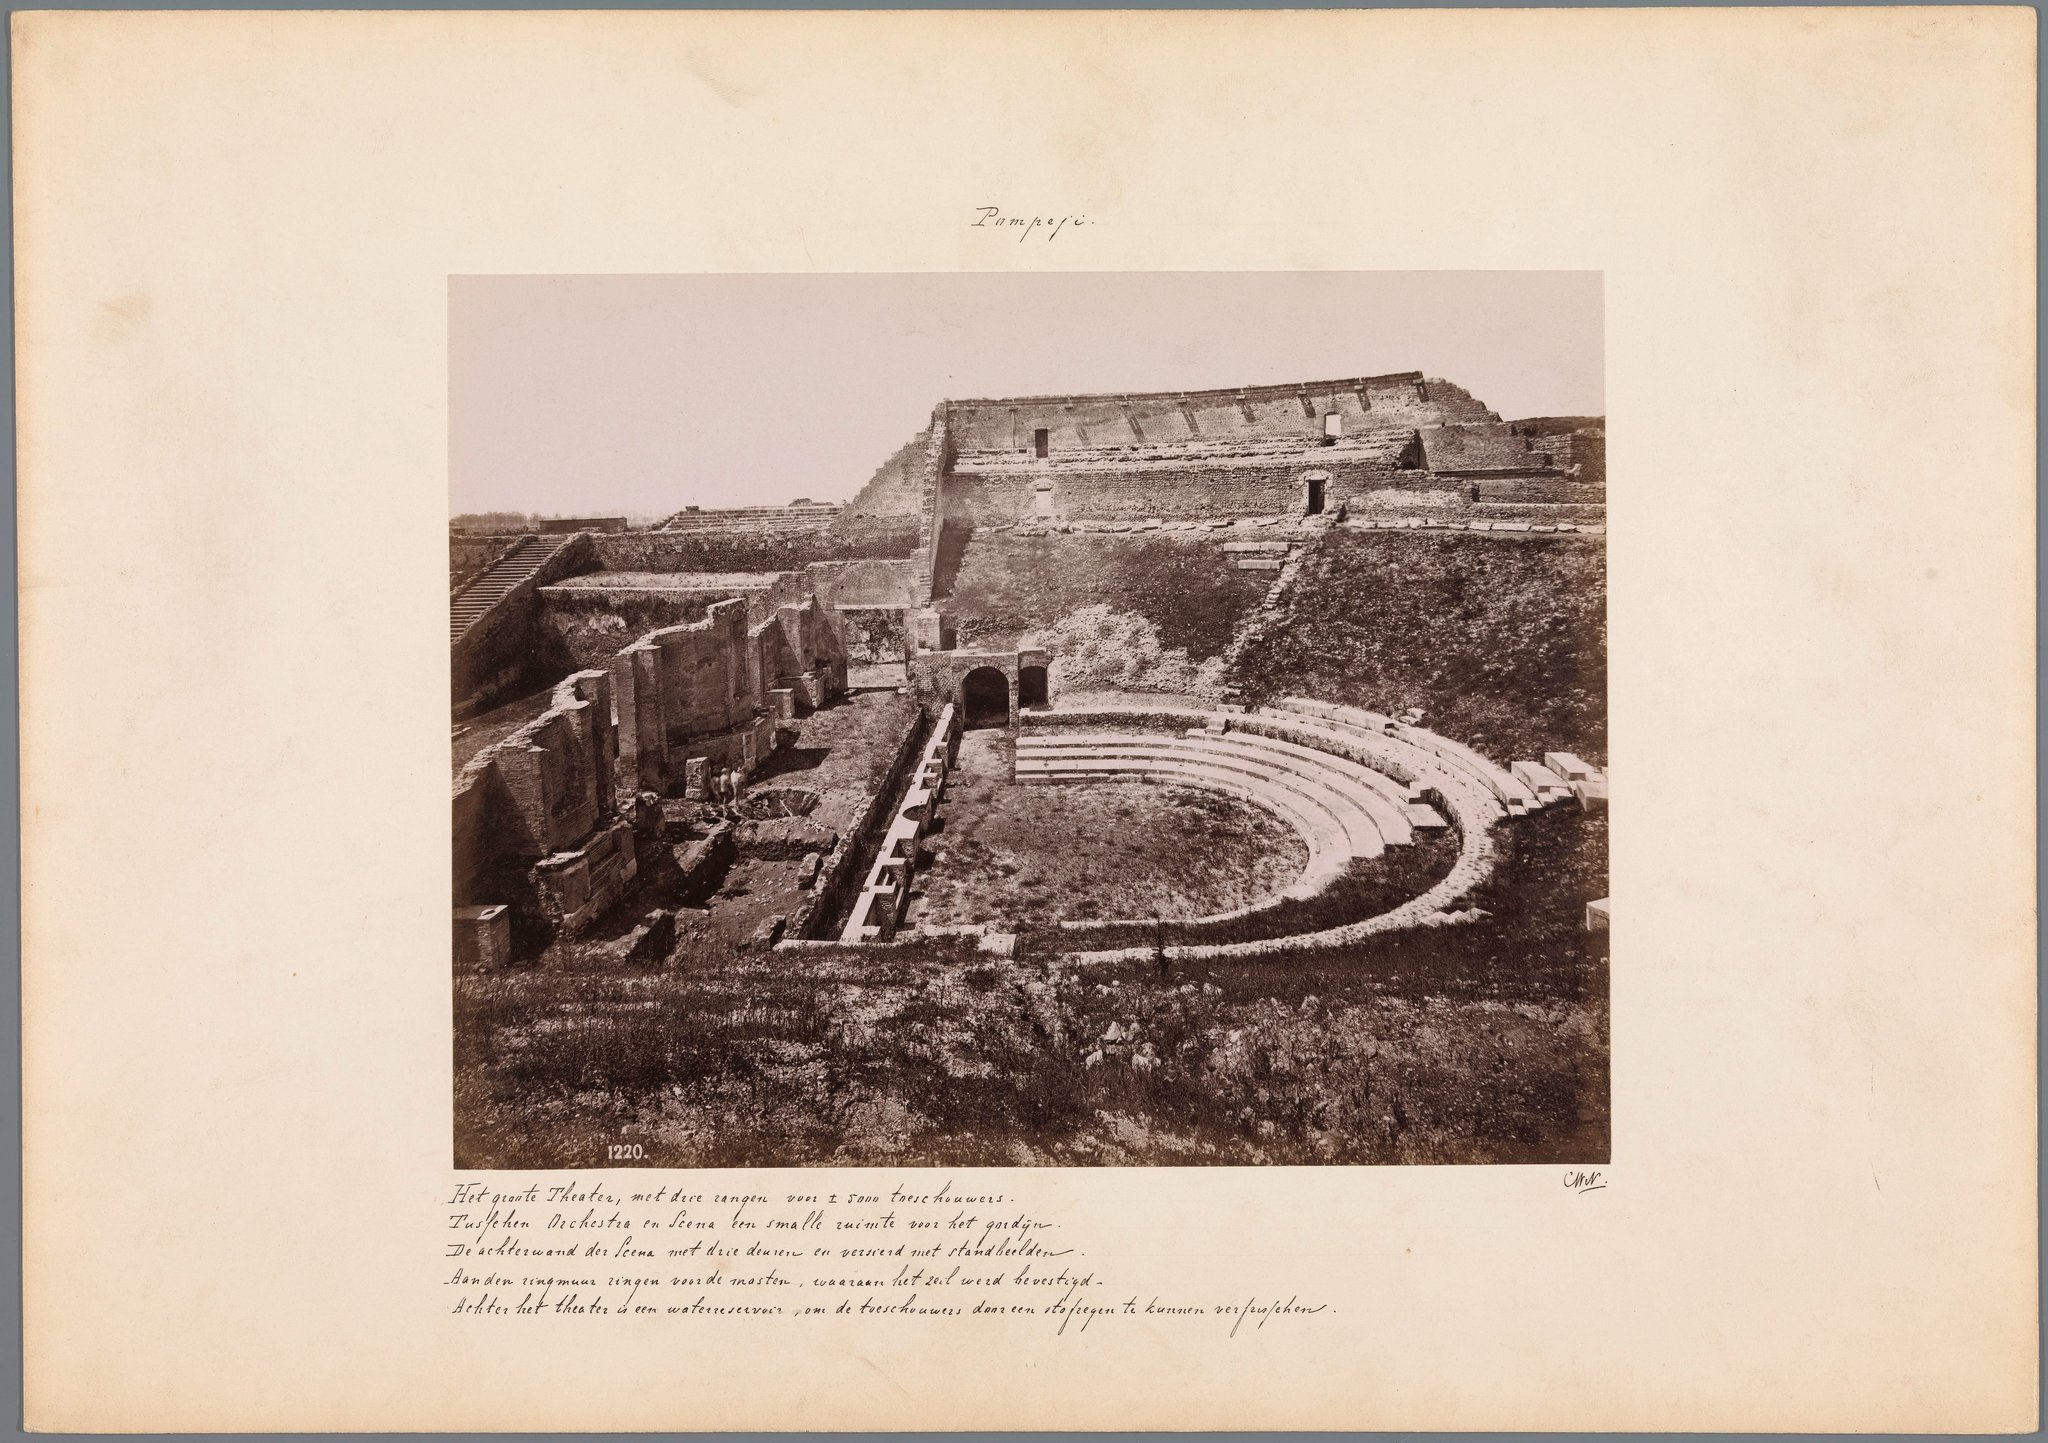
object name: photograph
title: Gezicht op een theater te Pompeï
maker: Anonymous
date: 1875-1900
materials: cardboard, photographic support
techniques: albumen print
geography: pompeii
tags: theatre (building) - aa - open-air performances, pompeii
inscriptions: collector's mark: ‘INSTITUUT VOOR KUNST-NIJVERHEIDSONDERWIJS GABRIËL METSUSTRAAT No. 16 AMSTERDAM’, inscription: ‘Pompeji.’, inscription: ‘CWN.’, number: ‘1220.’, collector's mark: ‘KUNSTNIJVERHEIDSCHOOL QUELLINUS AMSTERDAM FRANS HALSSTRAAT 14.’